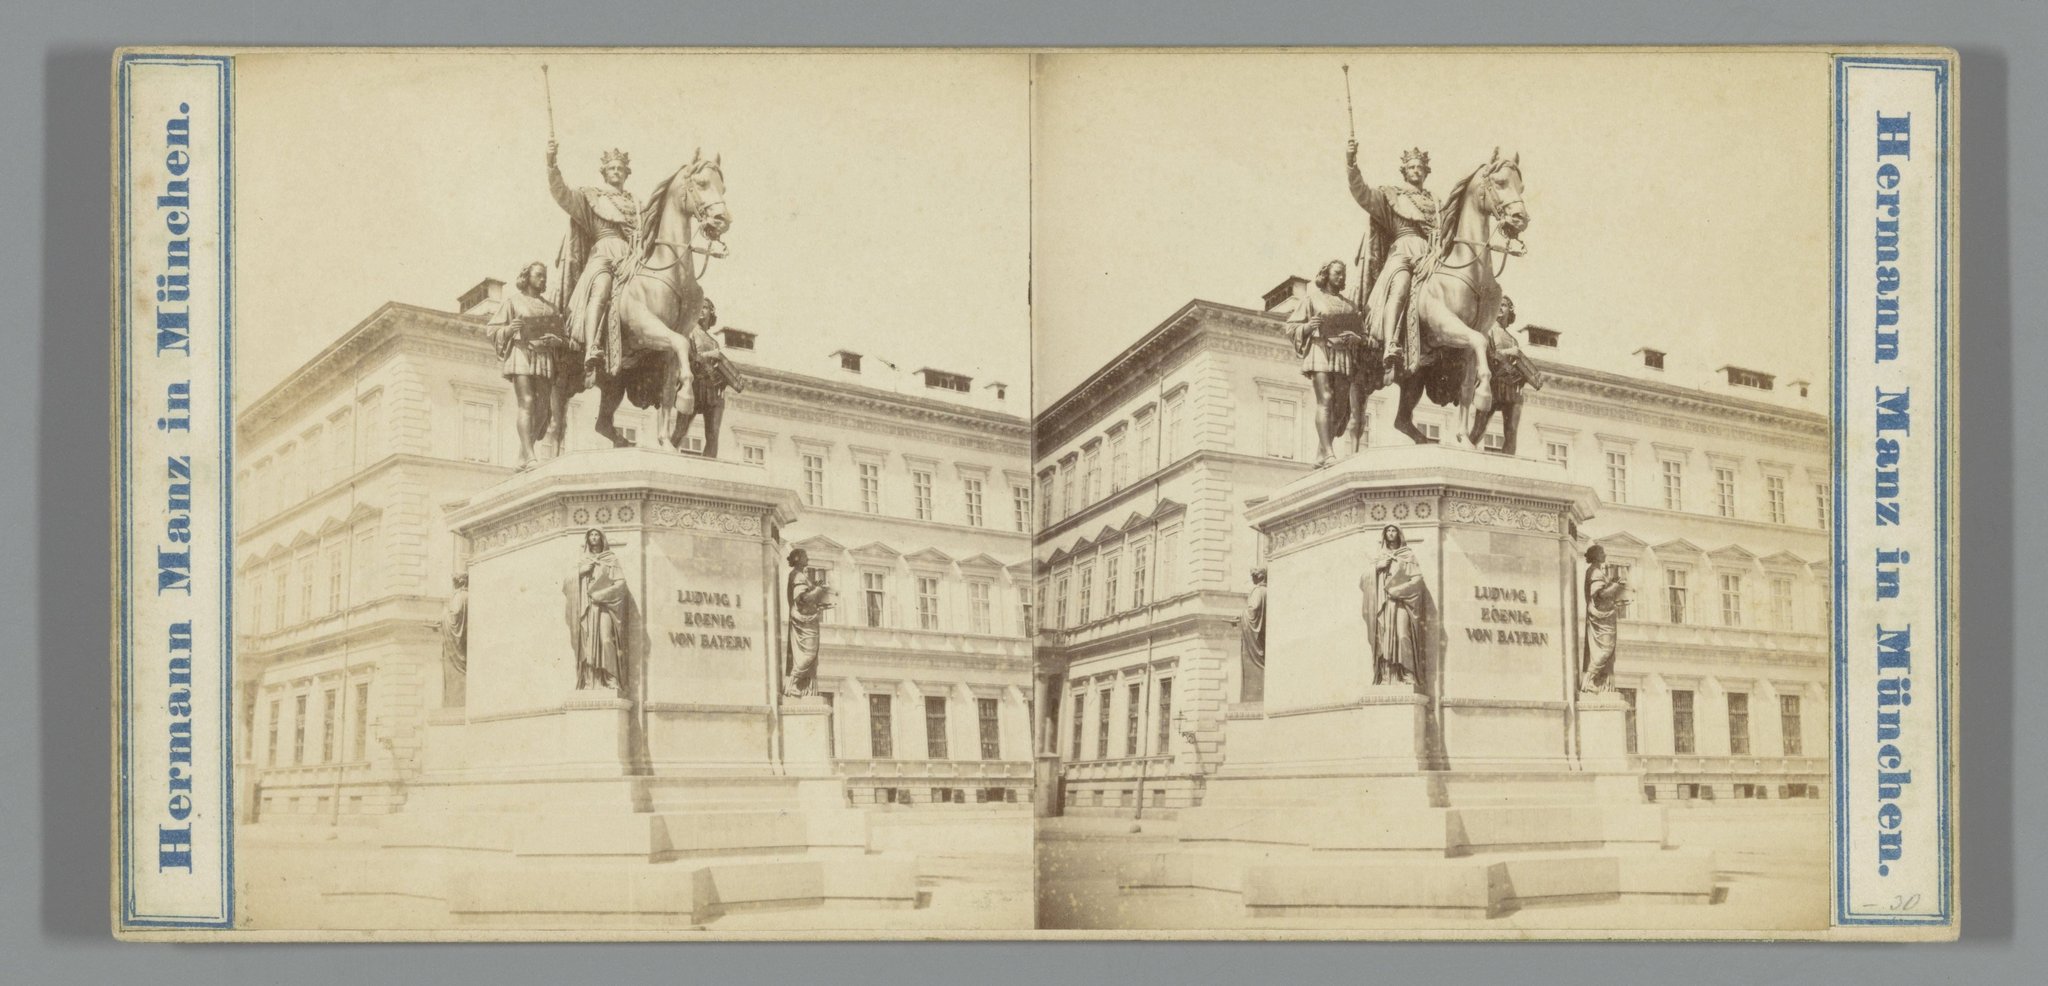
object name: stereograph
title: Ruiterstandbeeld van koning Lodewijk I van Beieren te München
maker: hermann manz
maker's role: fotograaf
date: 1860-1885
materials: cardboard, photographic support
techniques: albumen print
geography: munich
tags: equestrian statue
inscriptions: inscription: ‘Kgl. Hofkunsthandlung von Hermann Manz in München’, number: ‘Nr. 5.’